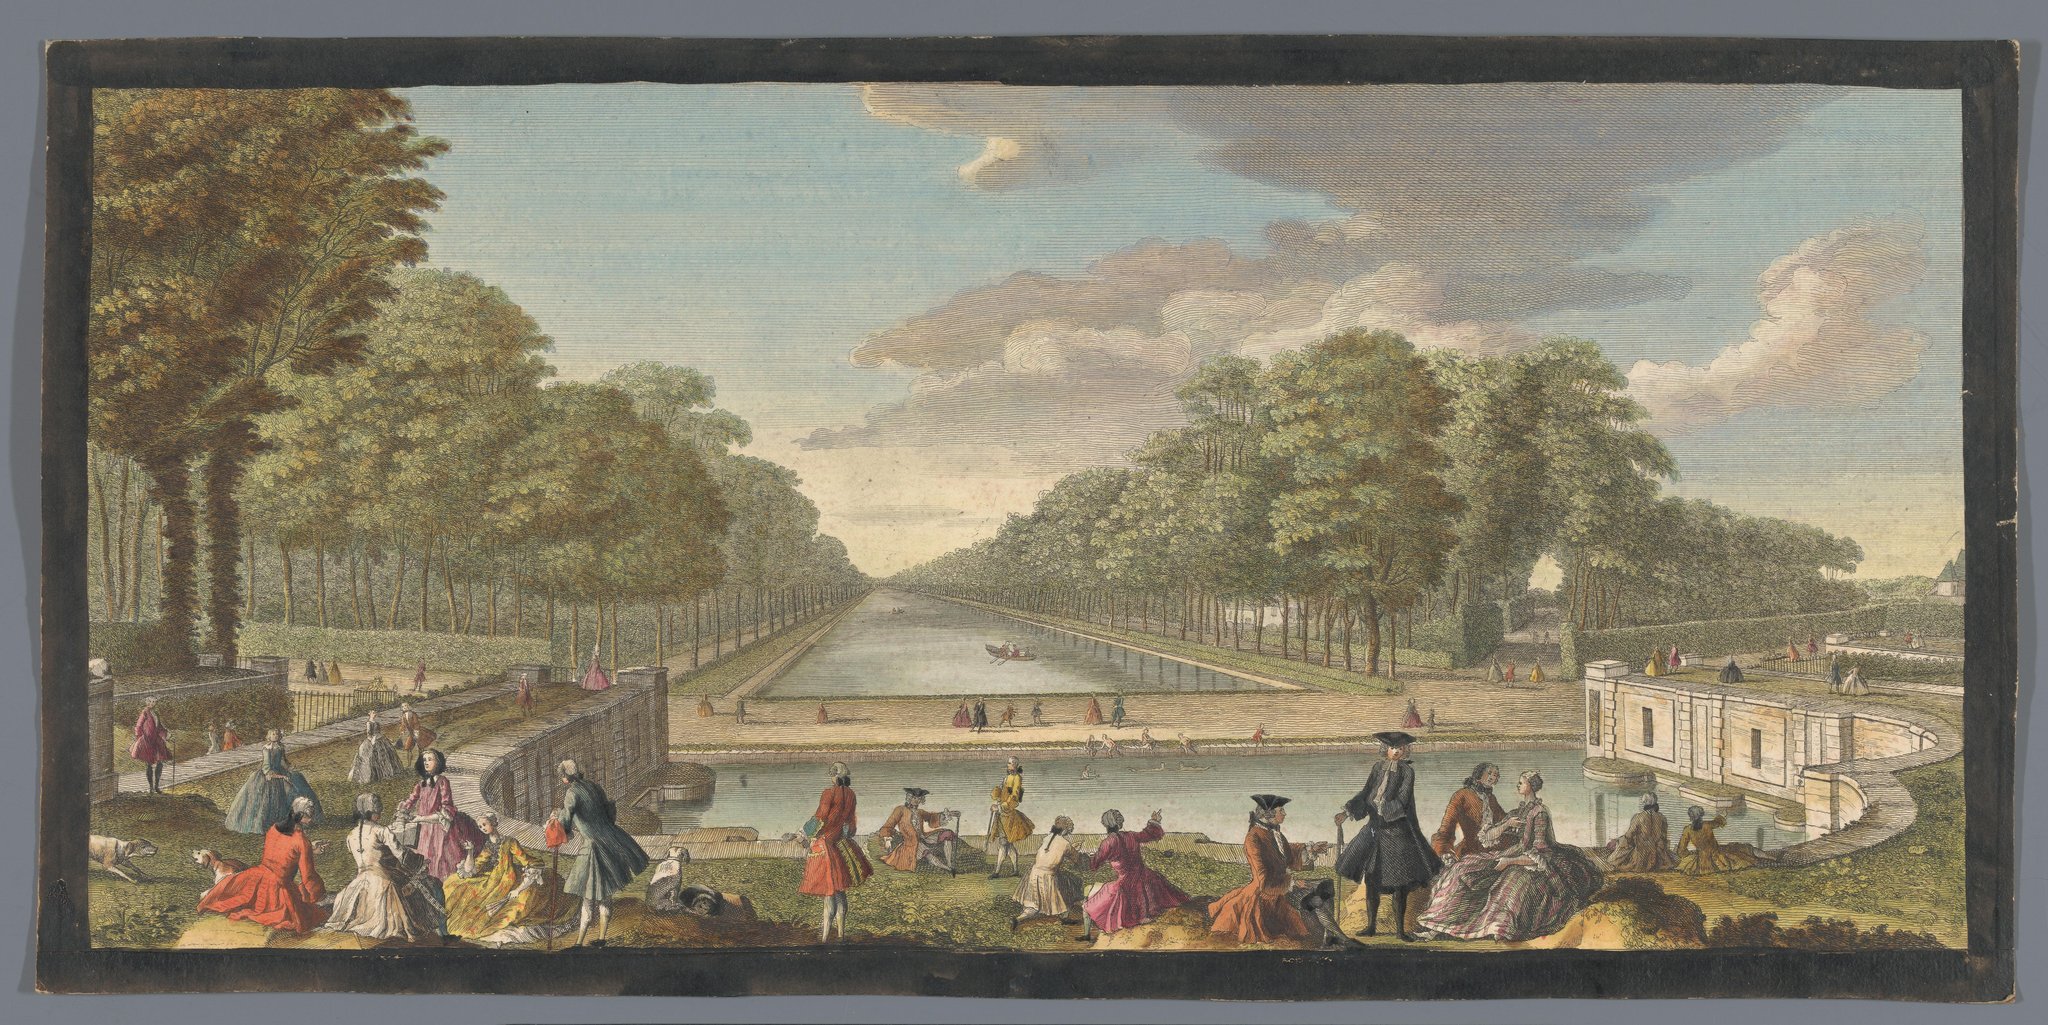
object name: print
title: Gezicht op het Grand Canal in de tuin van het Palais de Fontainebleau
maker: Anonymous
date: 1700-1799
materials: cardboard, paper, watercolor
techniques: brush, etching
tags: garden, water-works in garden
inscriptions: inscription: ‘Fo 16 B4’